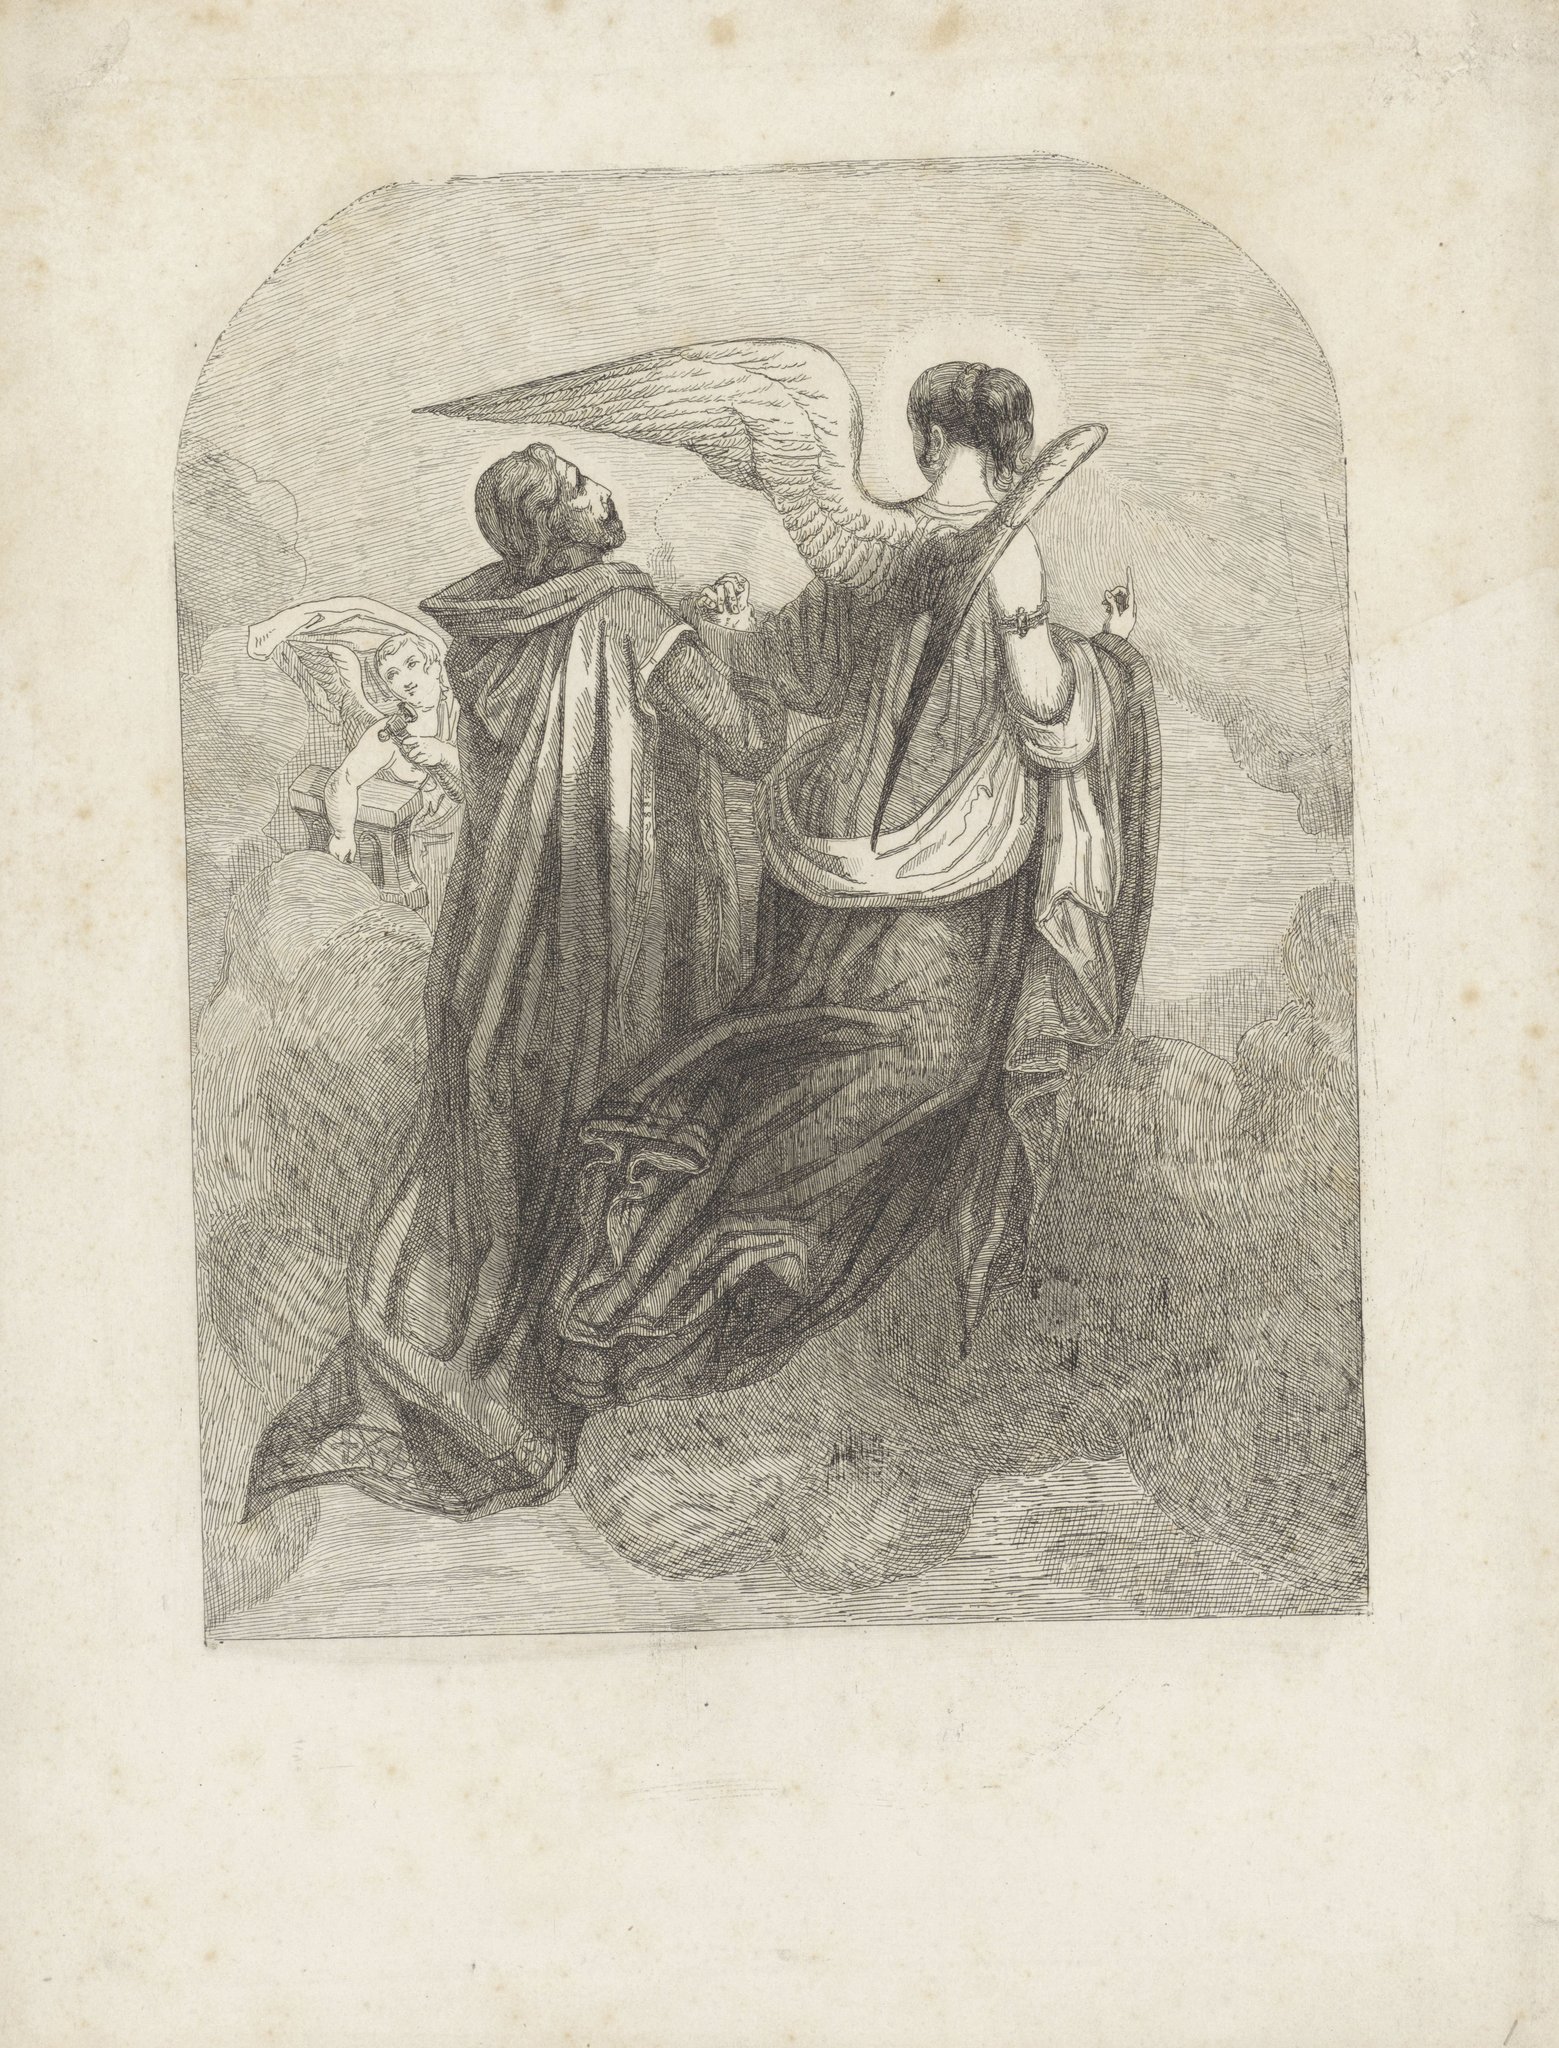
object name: print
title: Hemelvaart van een heilige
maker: theodoor schaepkens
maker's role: draughtsman, print maker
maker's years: 1810-1883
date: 1825-1883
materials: paper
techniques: etching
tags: male saints (with name) - apotheosis, glory, triumph of male saint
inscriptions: collector's mark: Lugt 2228